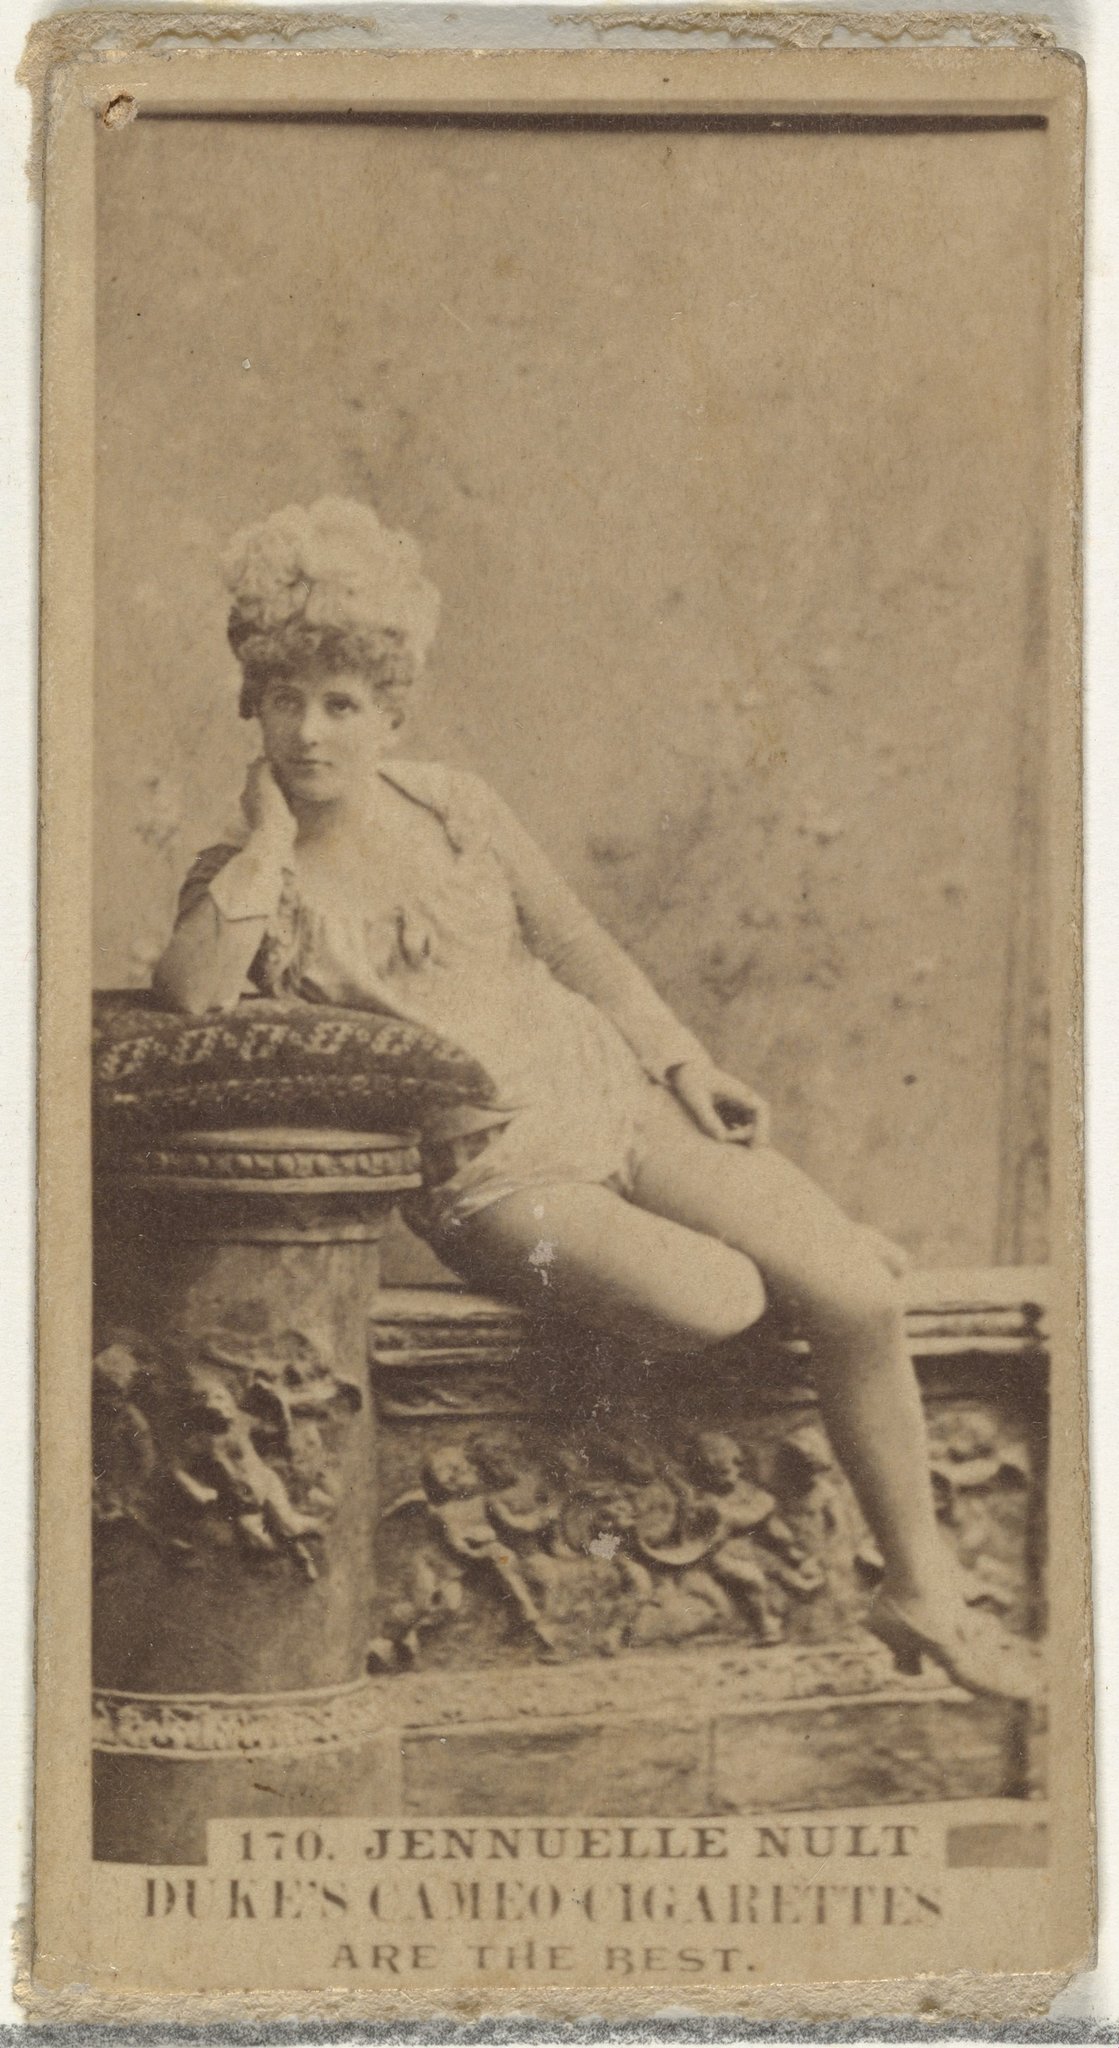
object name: photograph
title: Card Number 170, Jennuelle Nult, from the Actors and Actresses series (N145-5) issued by Duke Sons & Co. to promote Cameo Cigarettes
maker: w. duke, sons & co.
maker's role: publisher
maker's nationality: american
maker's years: 1870-1920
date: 1880-1889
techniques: albumen silver print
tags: portraits,women,actresses